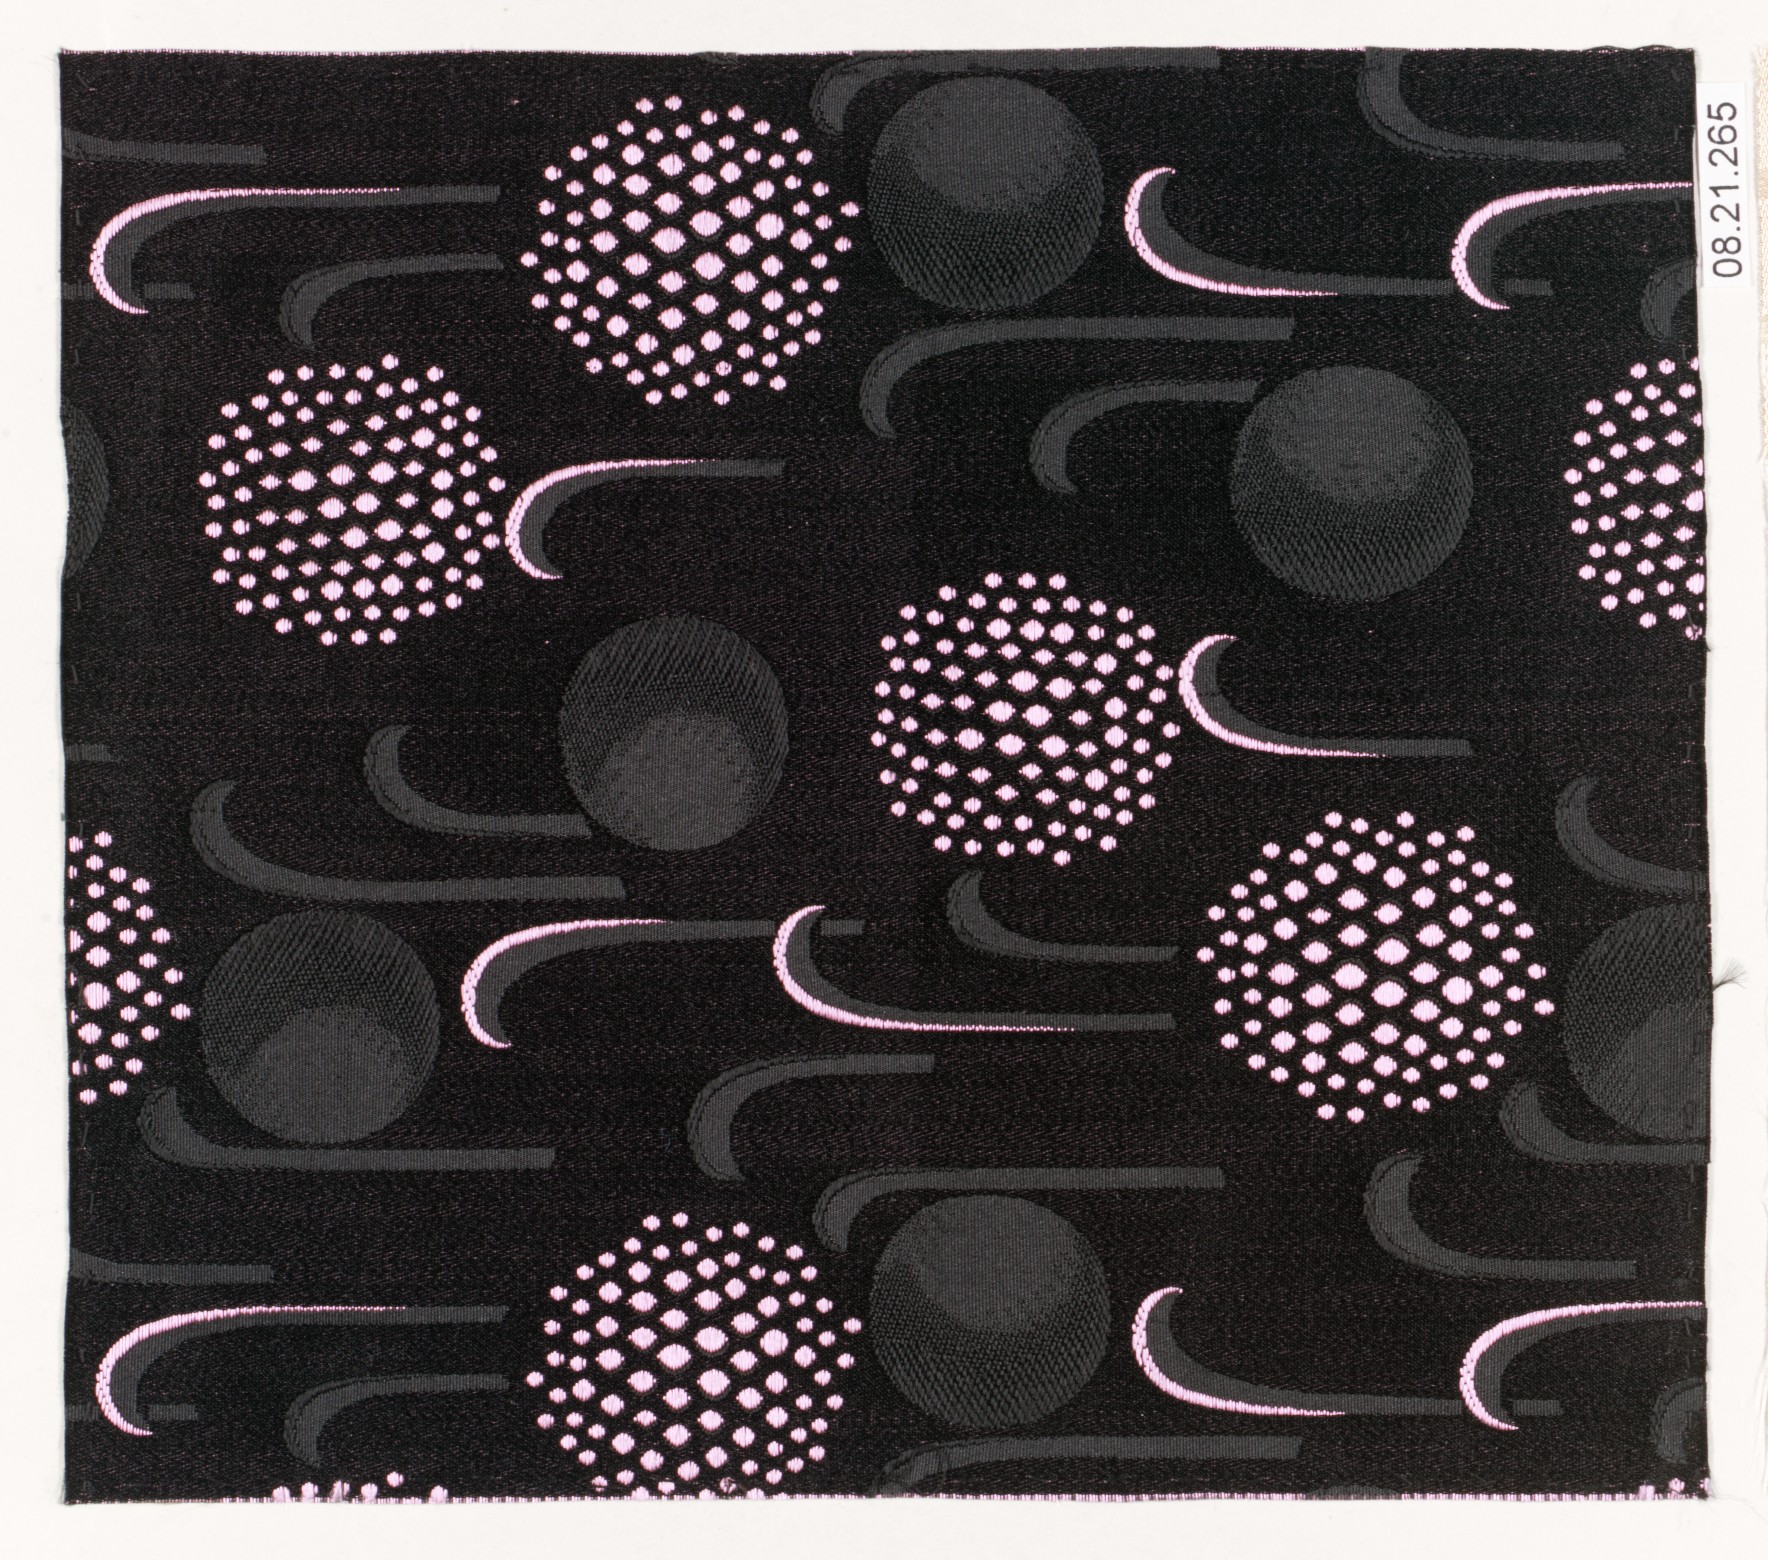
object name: textile sample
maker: Anonymous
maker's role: designer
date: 1900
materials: silk